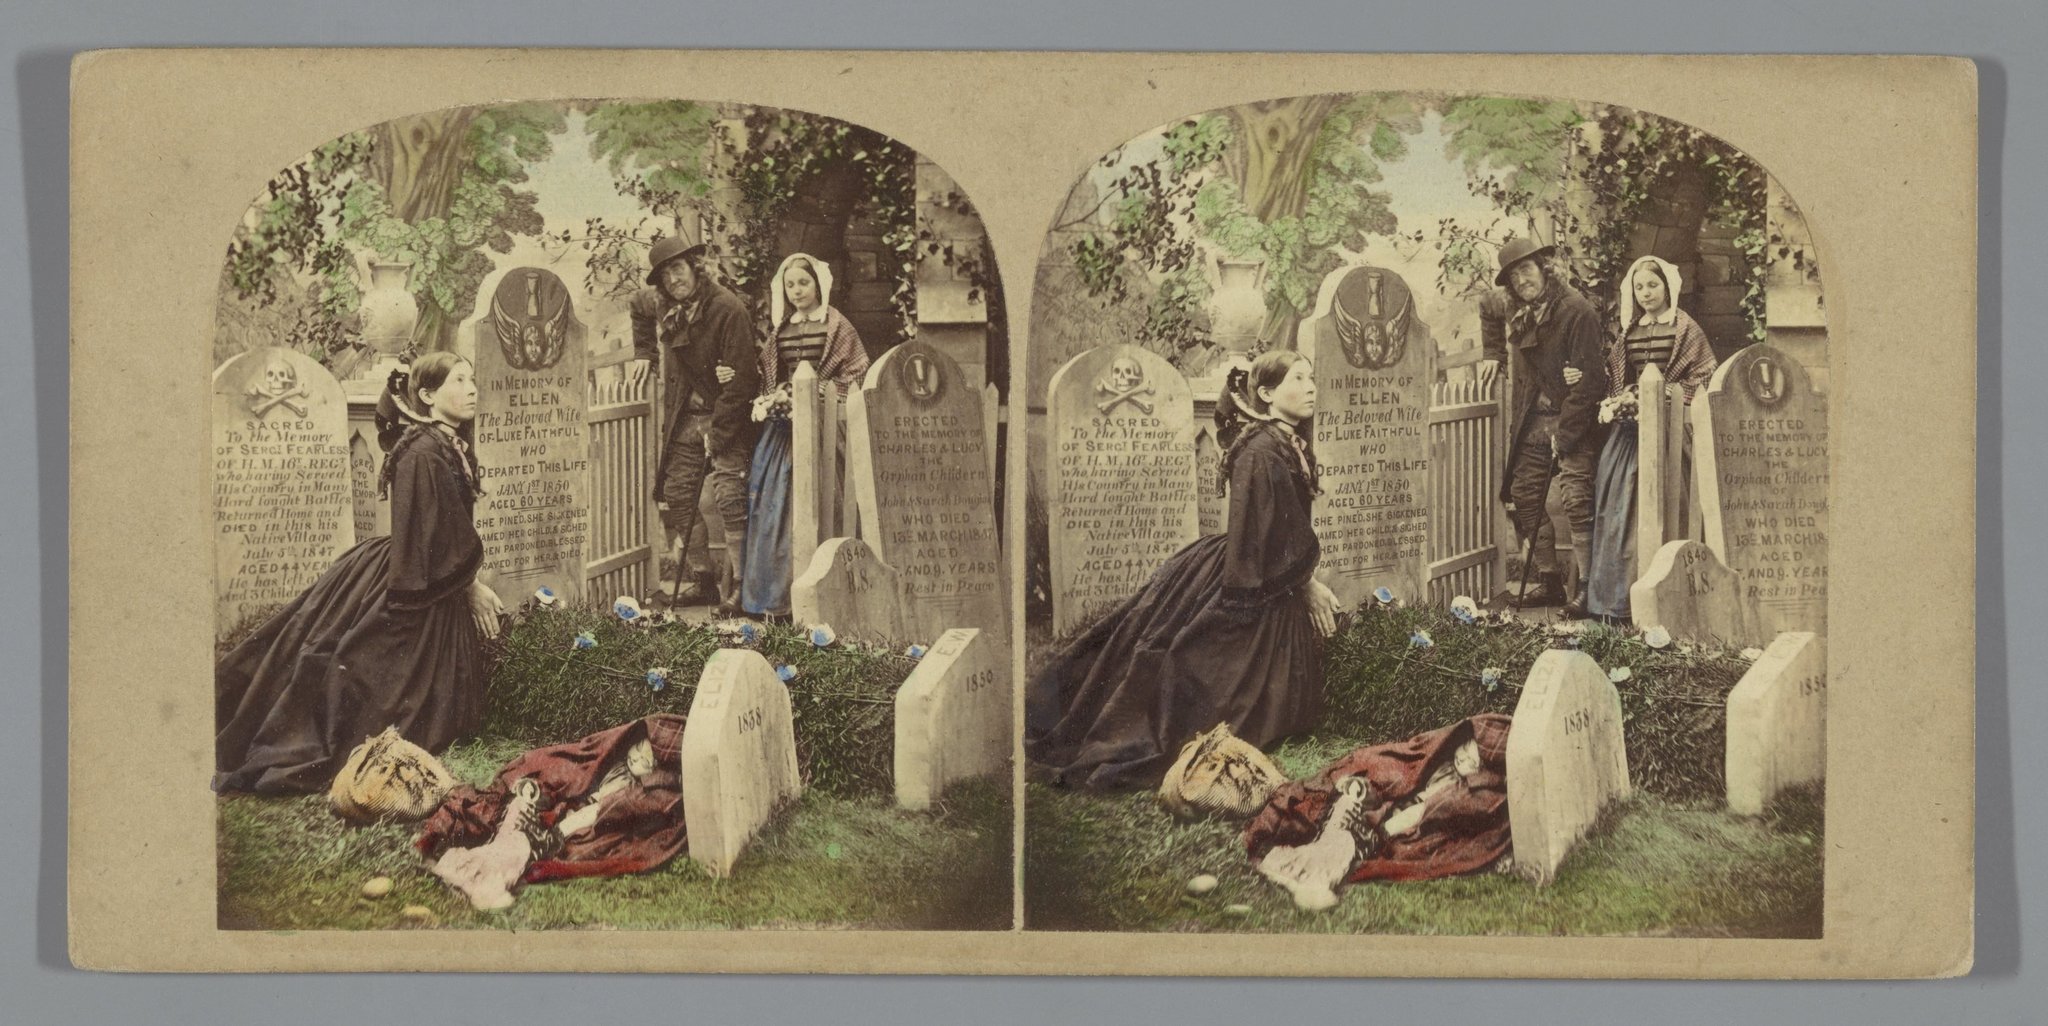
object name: stereograph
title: The Return of the Wanderer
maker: Anonymous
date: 1852-1863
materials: cardboard, paper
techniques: albumen print, hand coloring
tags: churchyard, cemetery